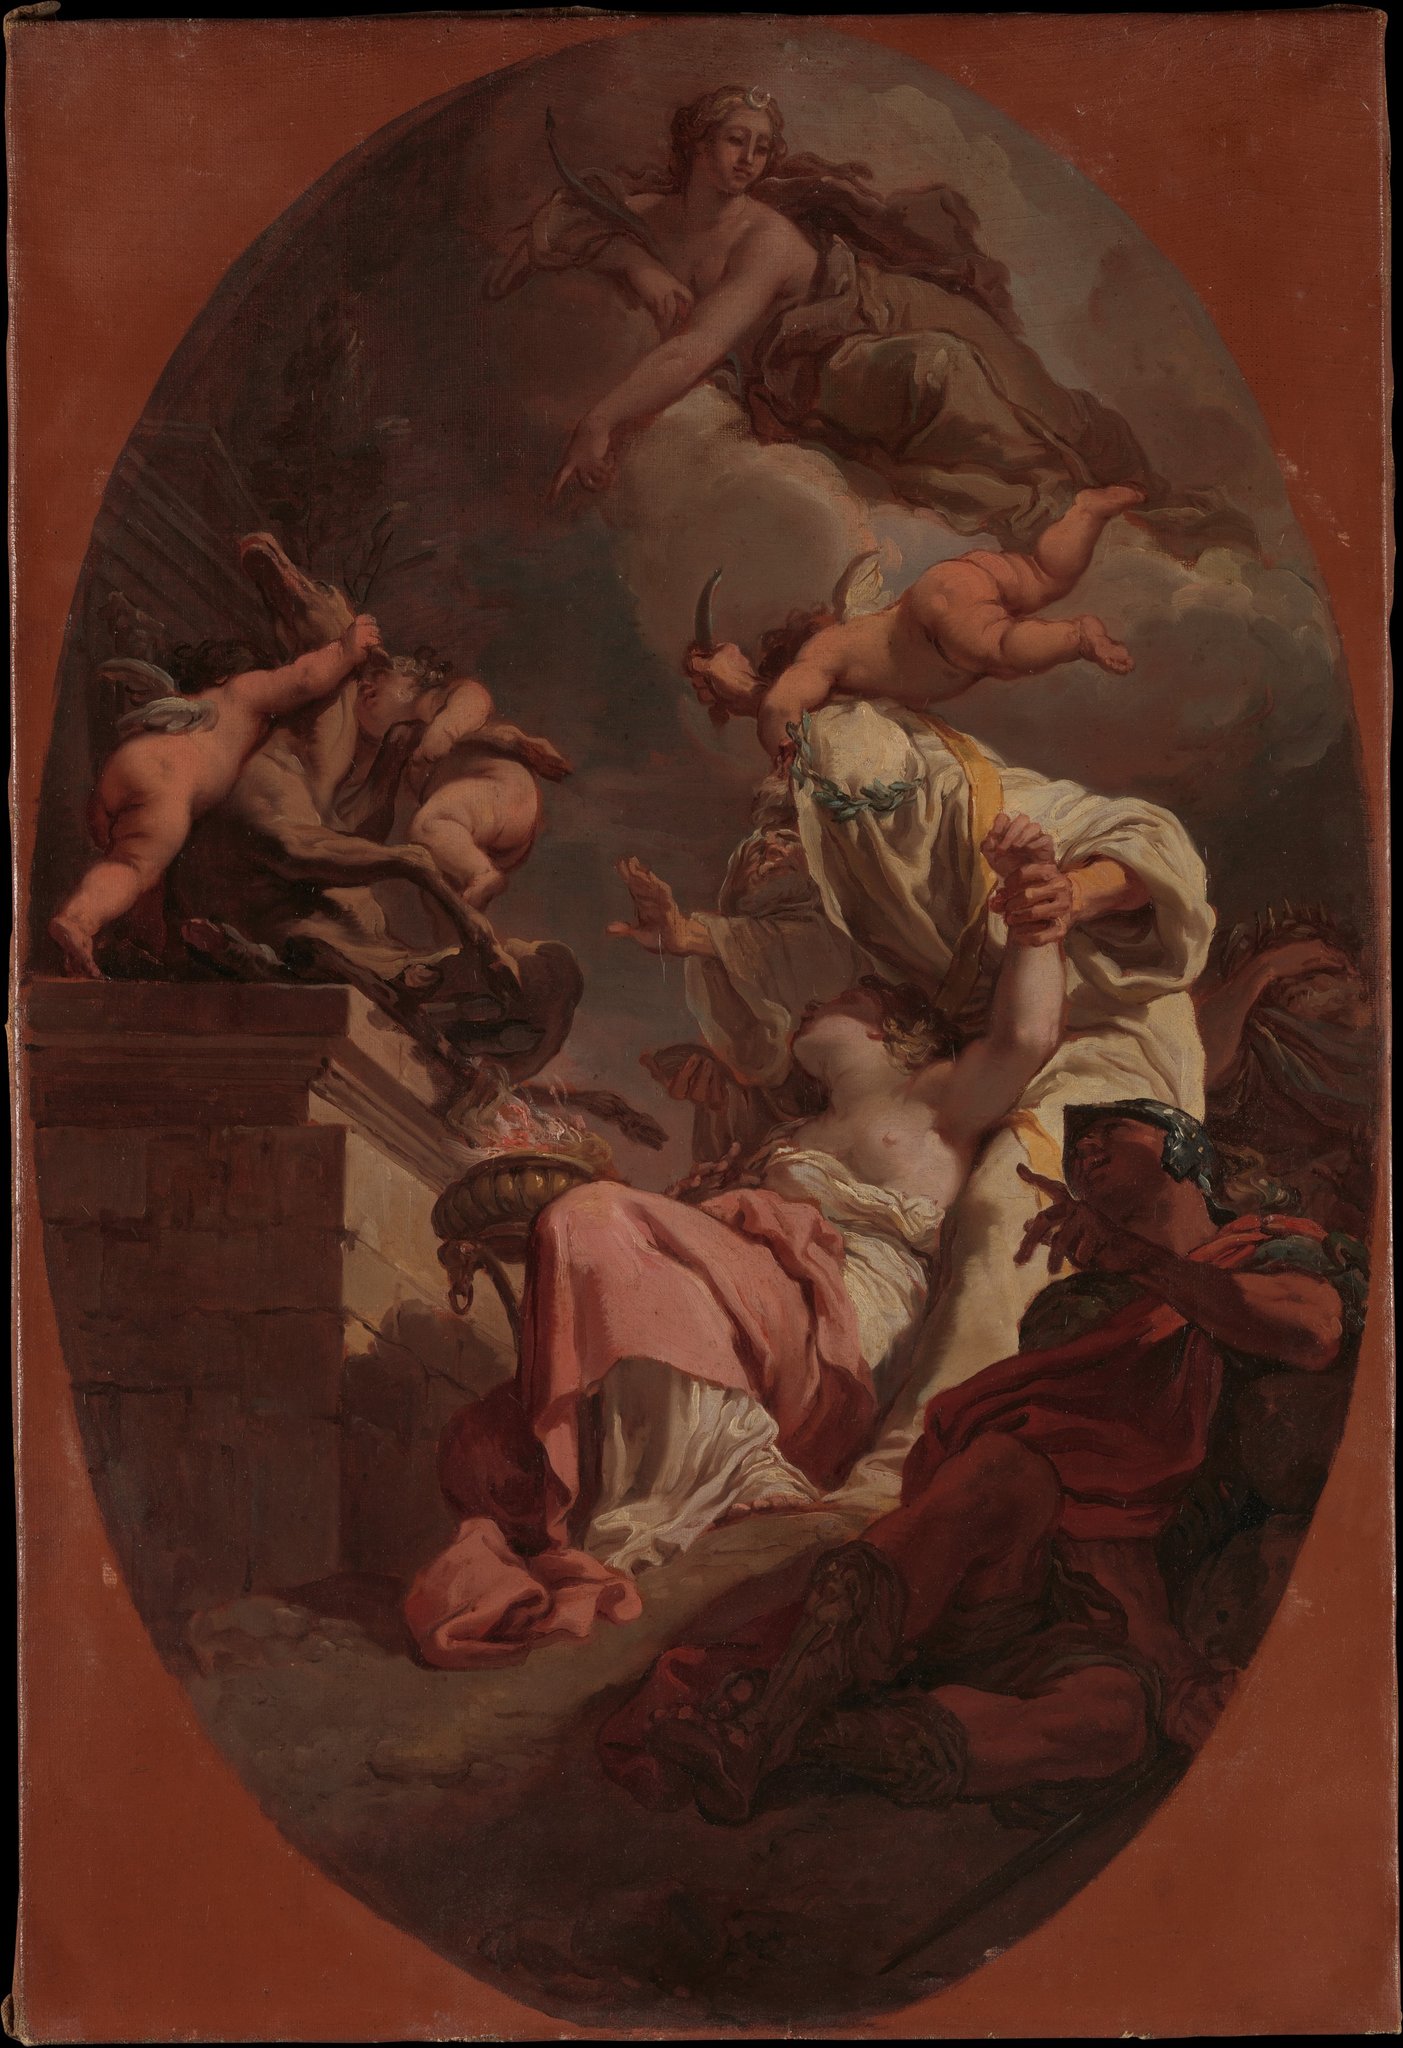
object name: painting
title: The Sacrifice of Iphigenia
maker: gaetano gandolfi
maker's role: artist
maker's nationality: italian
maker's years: 1734-1802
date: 1789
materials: canvas, oil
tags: putti,diana,deer